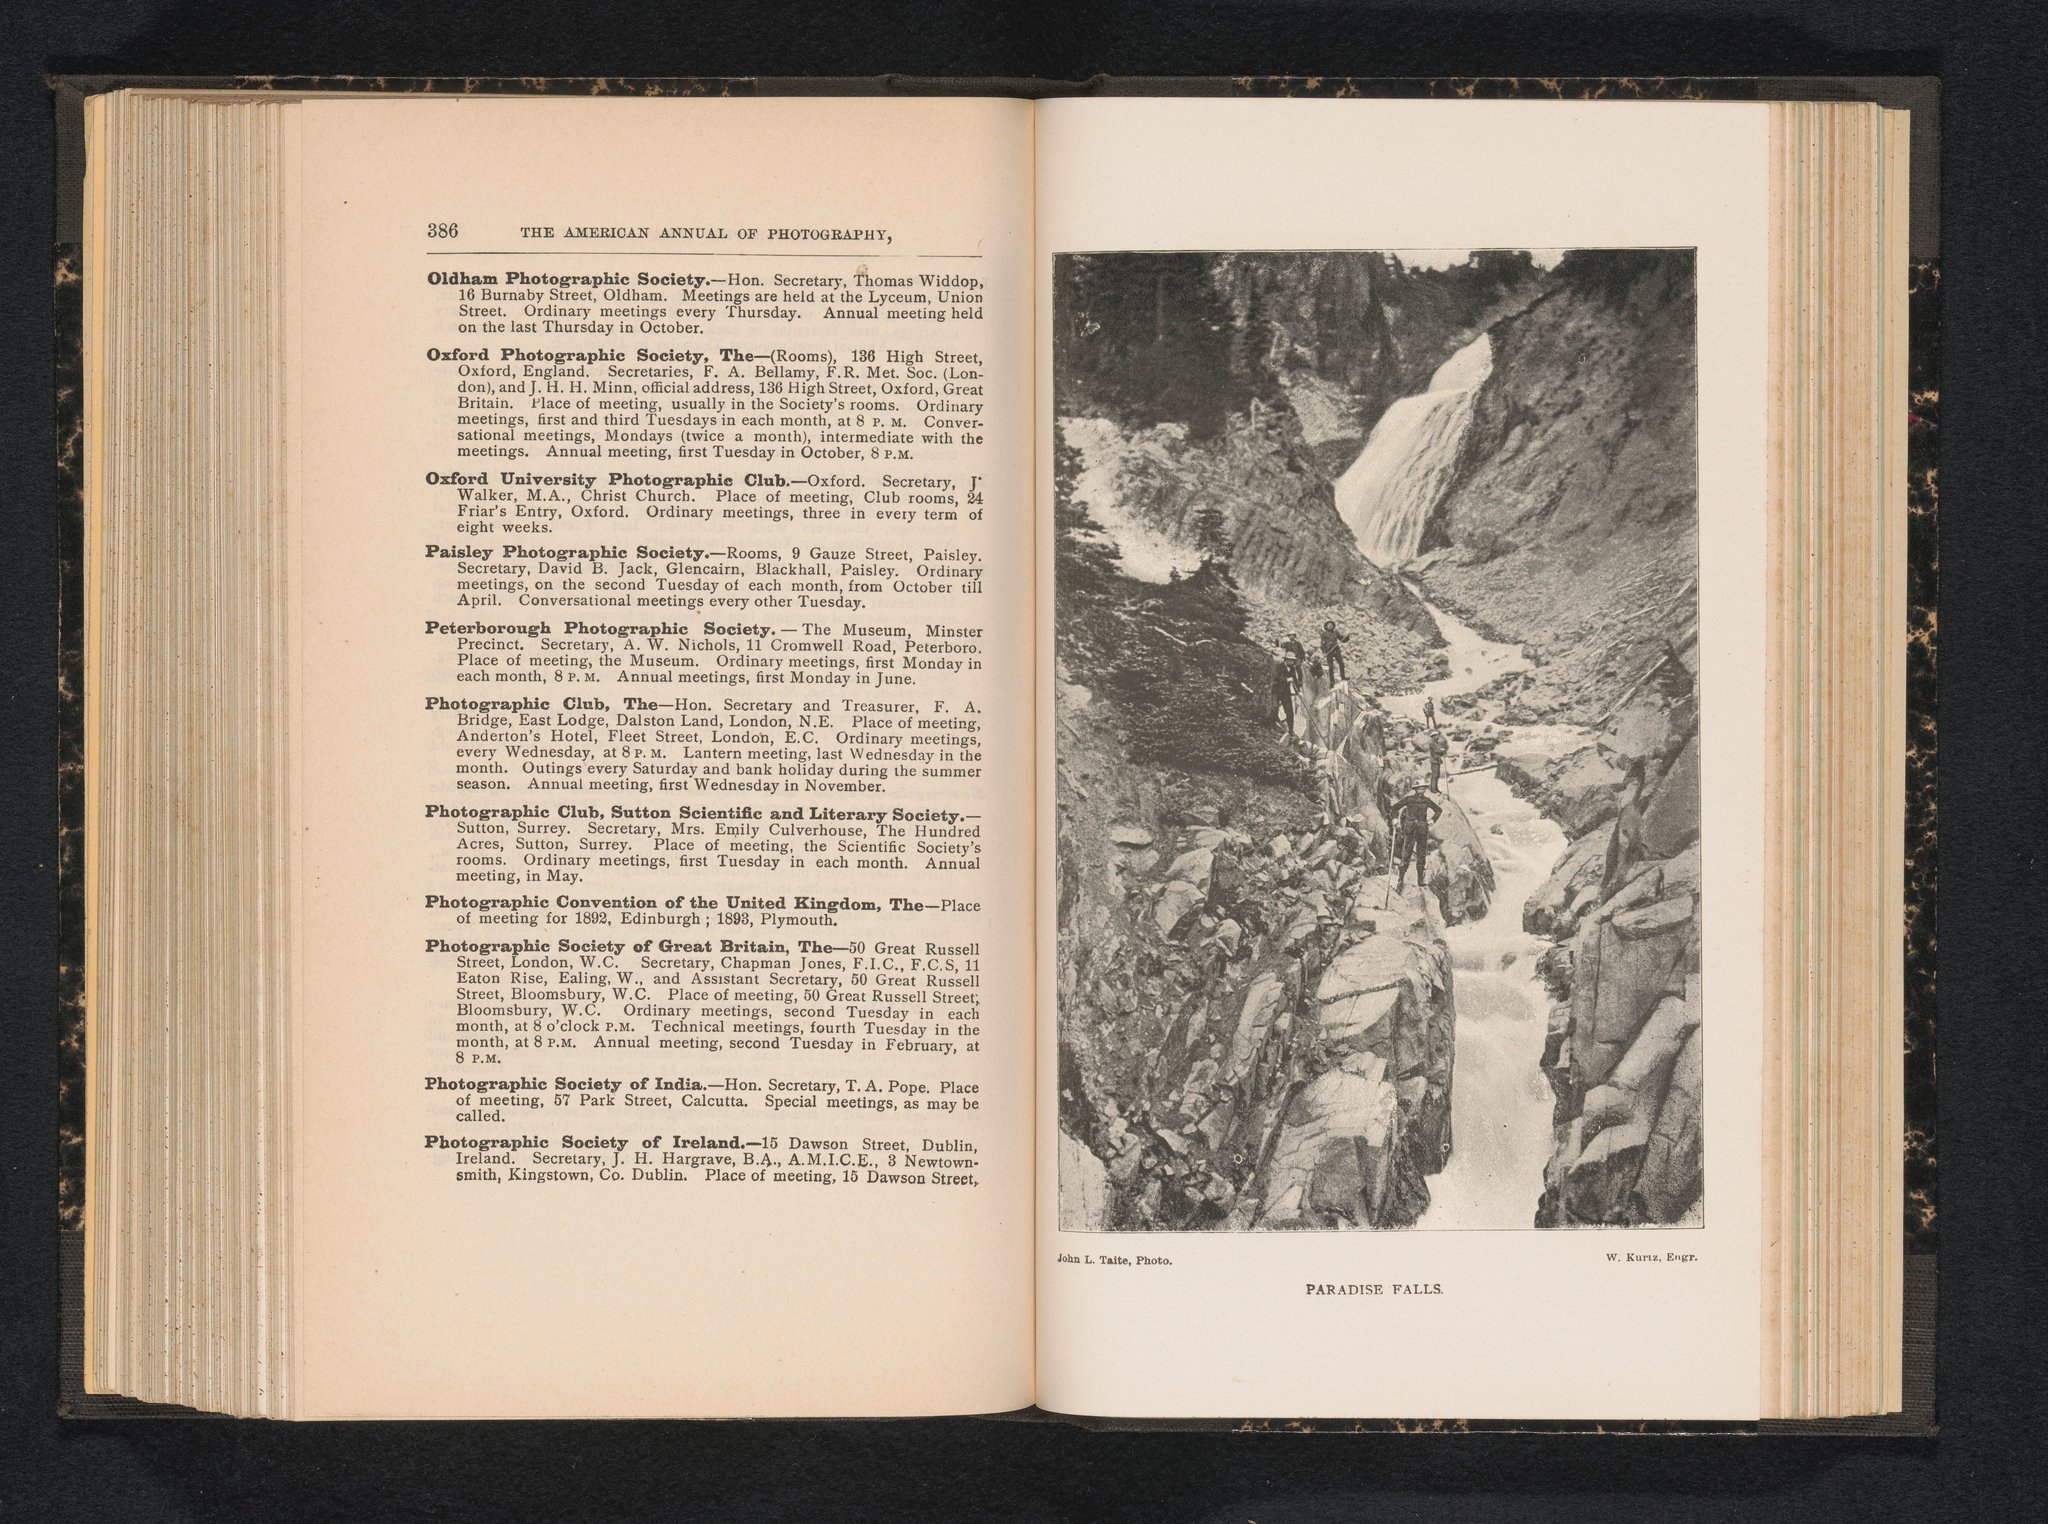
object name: photomechanical print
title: Gezicht op een groep bergbeklimmers bij een waterval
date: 1887-1907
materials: paper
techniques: autotype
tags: mountain climbing, mountaineering, waterfall